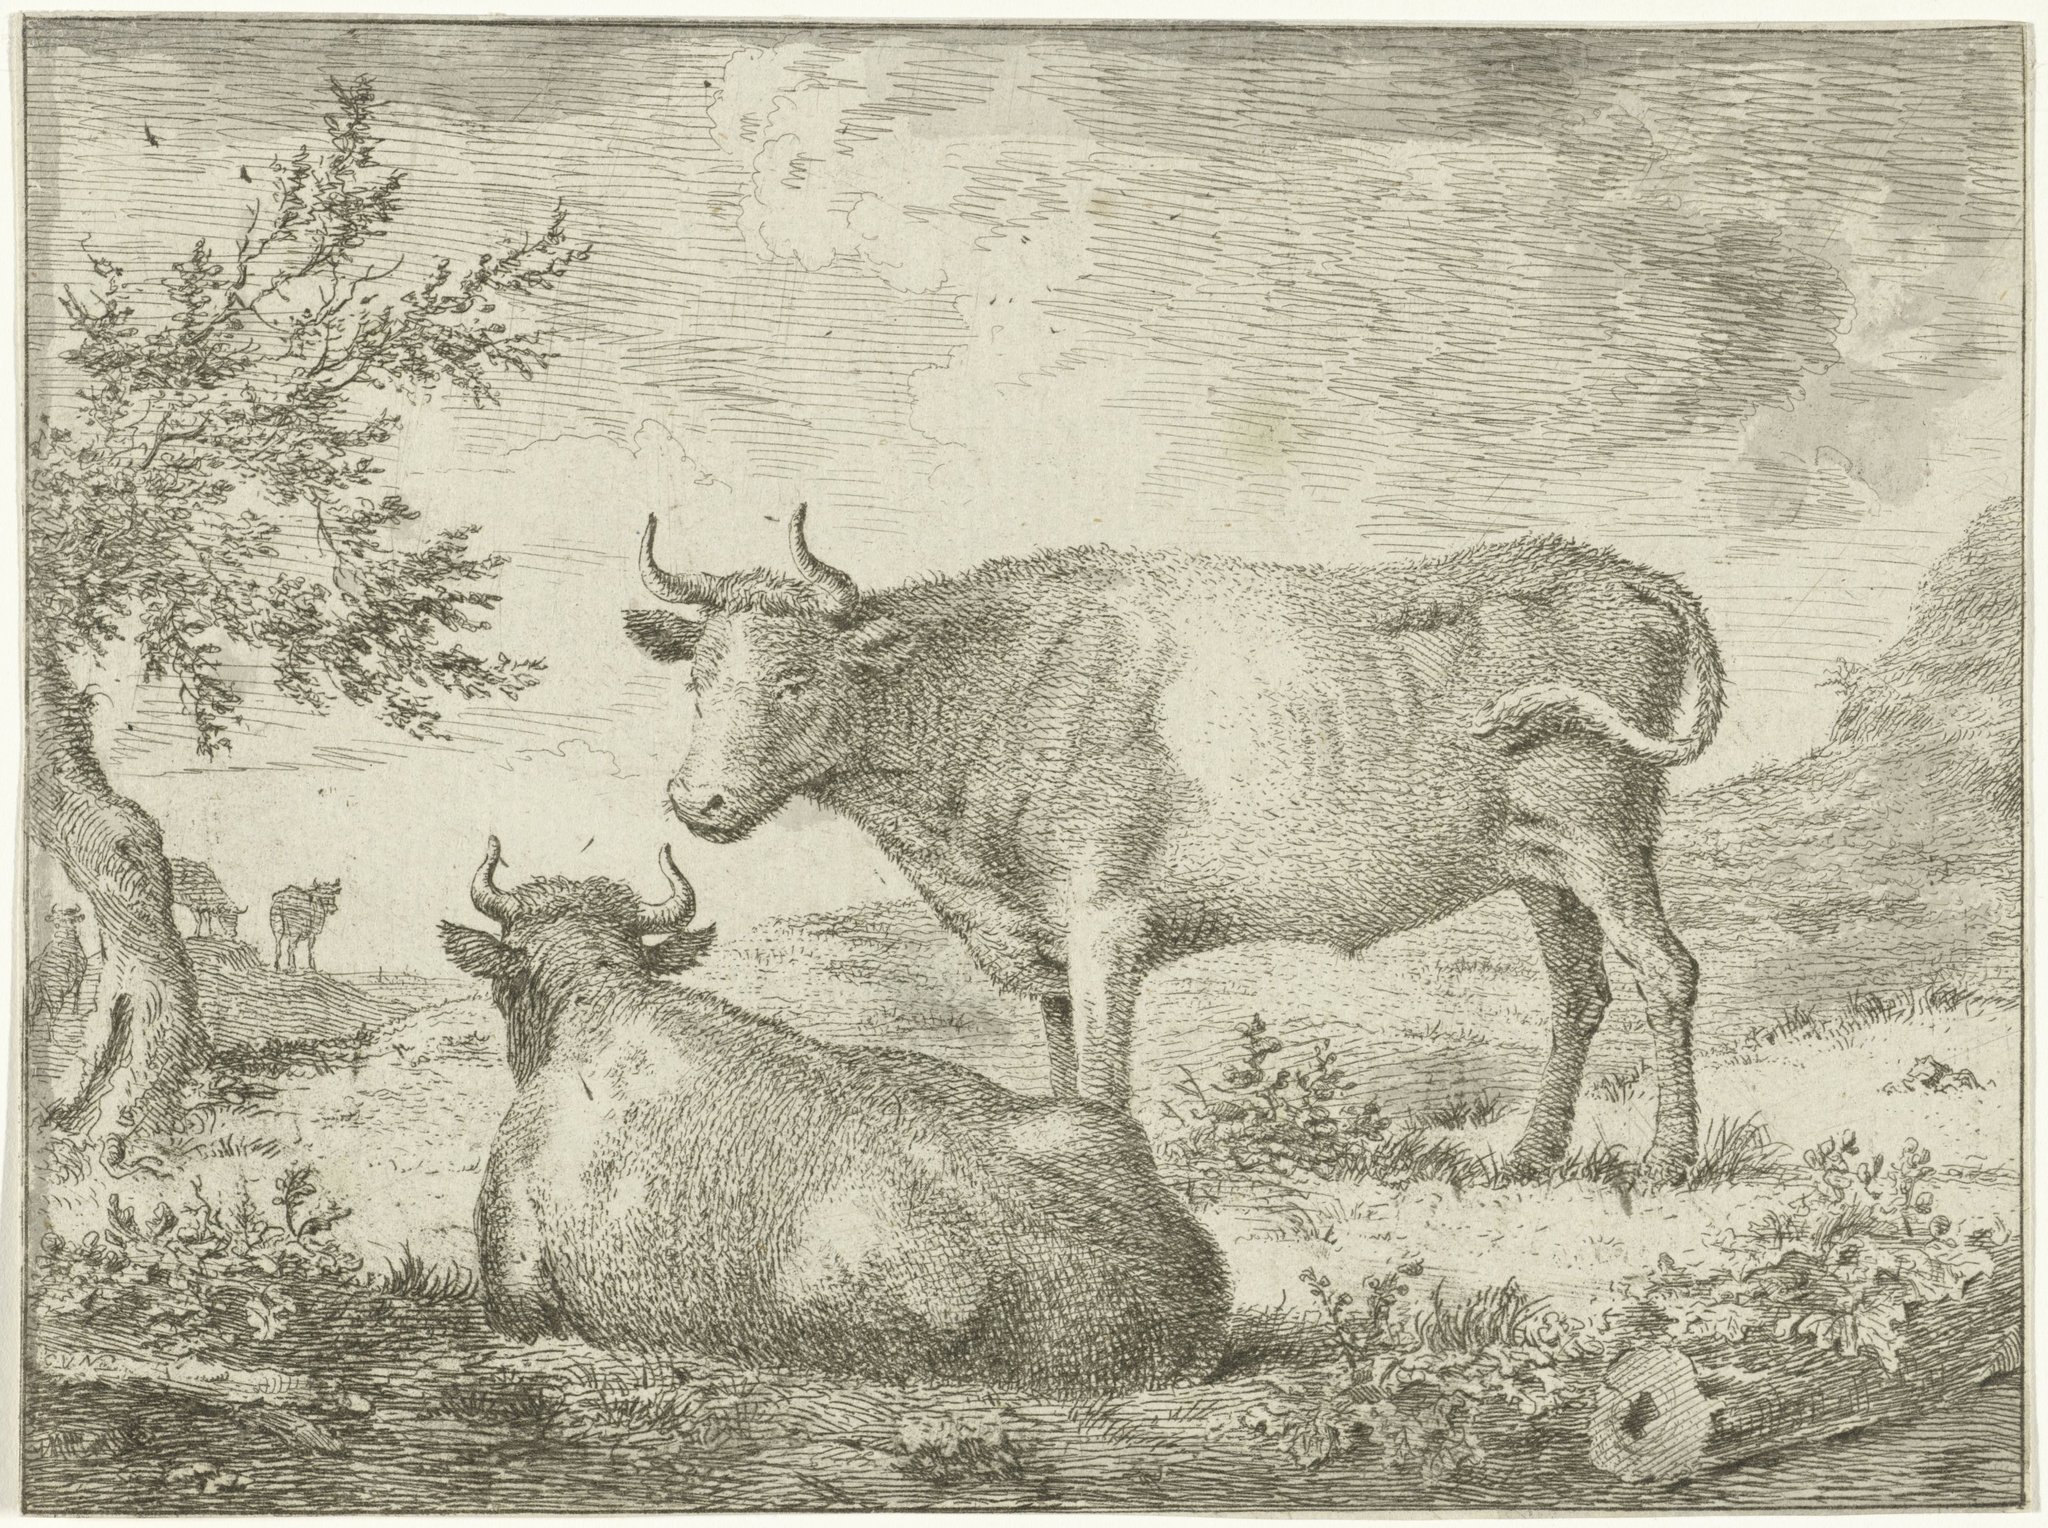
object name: print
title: Staande en liggende koe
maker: cornelis van noorde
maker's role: draughtsman, print maker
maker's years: 1731-1795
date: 1741-1795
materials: paper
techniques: brush, etching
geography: haarlem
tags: cow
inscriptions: collector's mark: Lugt 2228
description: Een staande en een liggende koe in een weiland. Links een boom en in de verte nog twee koeien.